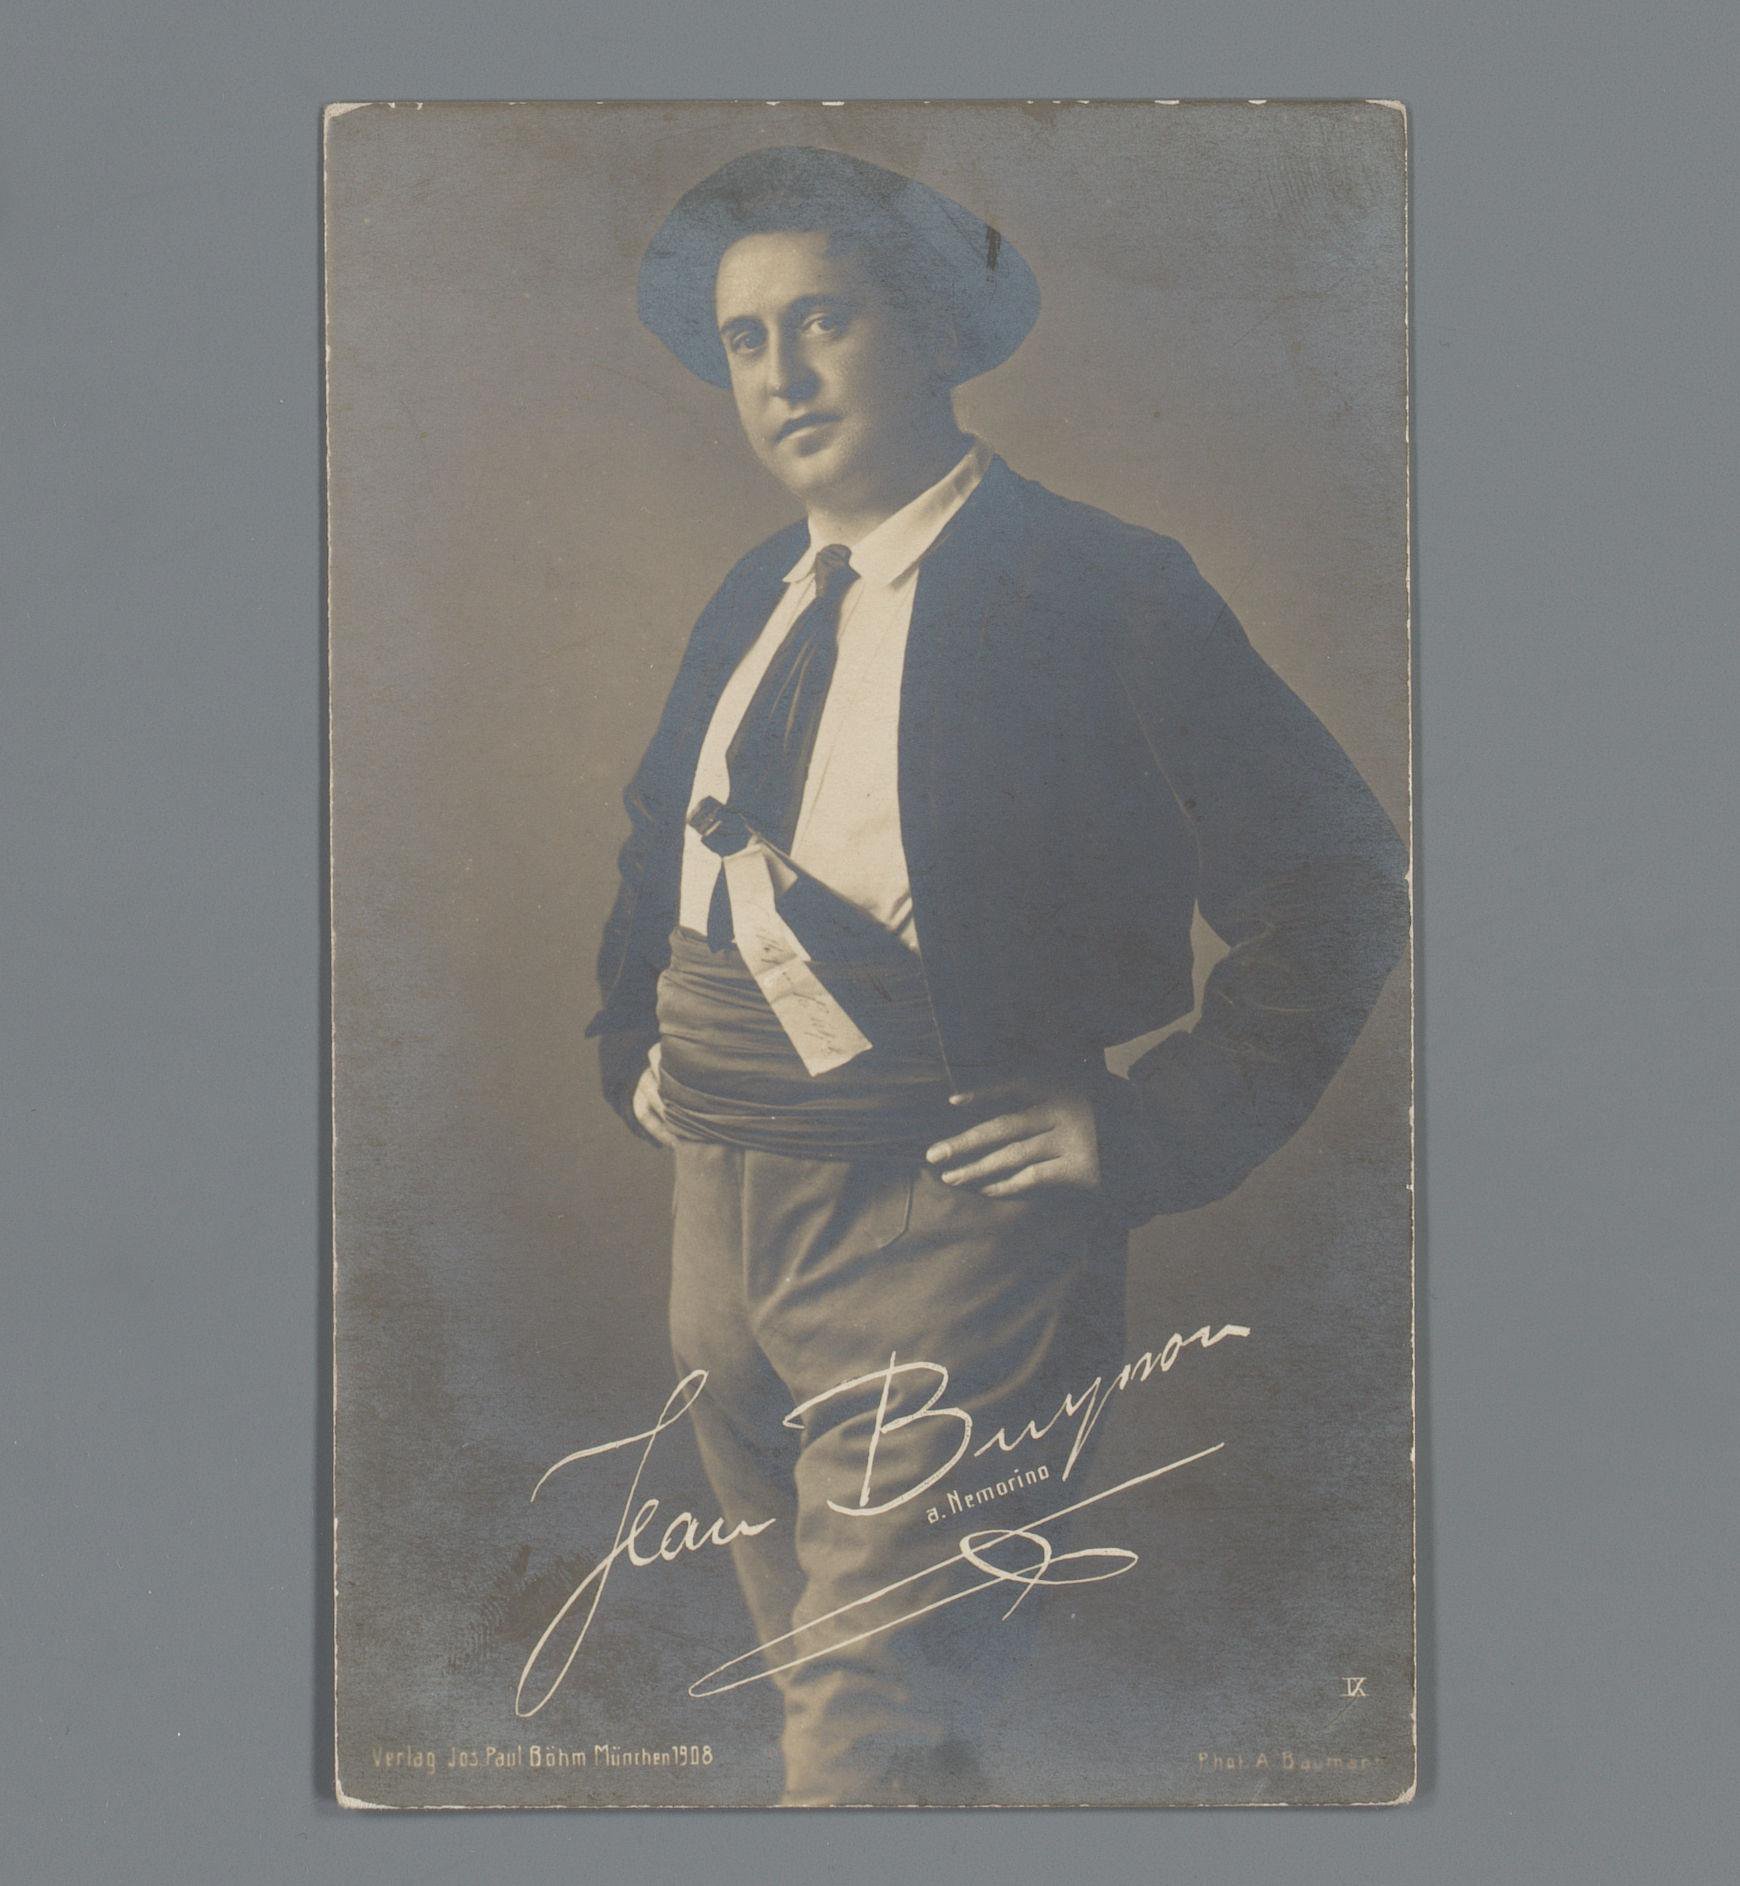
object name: ansichtkaart, prentbriefkaart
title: Jean Buysson a. Nemorino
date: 1908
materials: paper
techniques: gelatin silver print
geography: munich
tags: amsterdam, paris, historical persons (portraits and scenes from the life)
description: Portret van Jean Buysson als Nemorino in L'elisir d'amore.